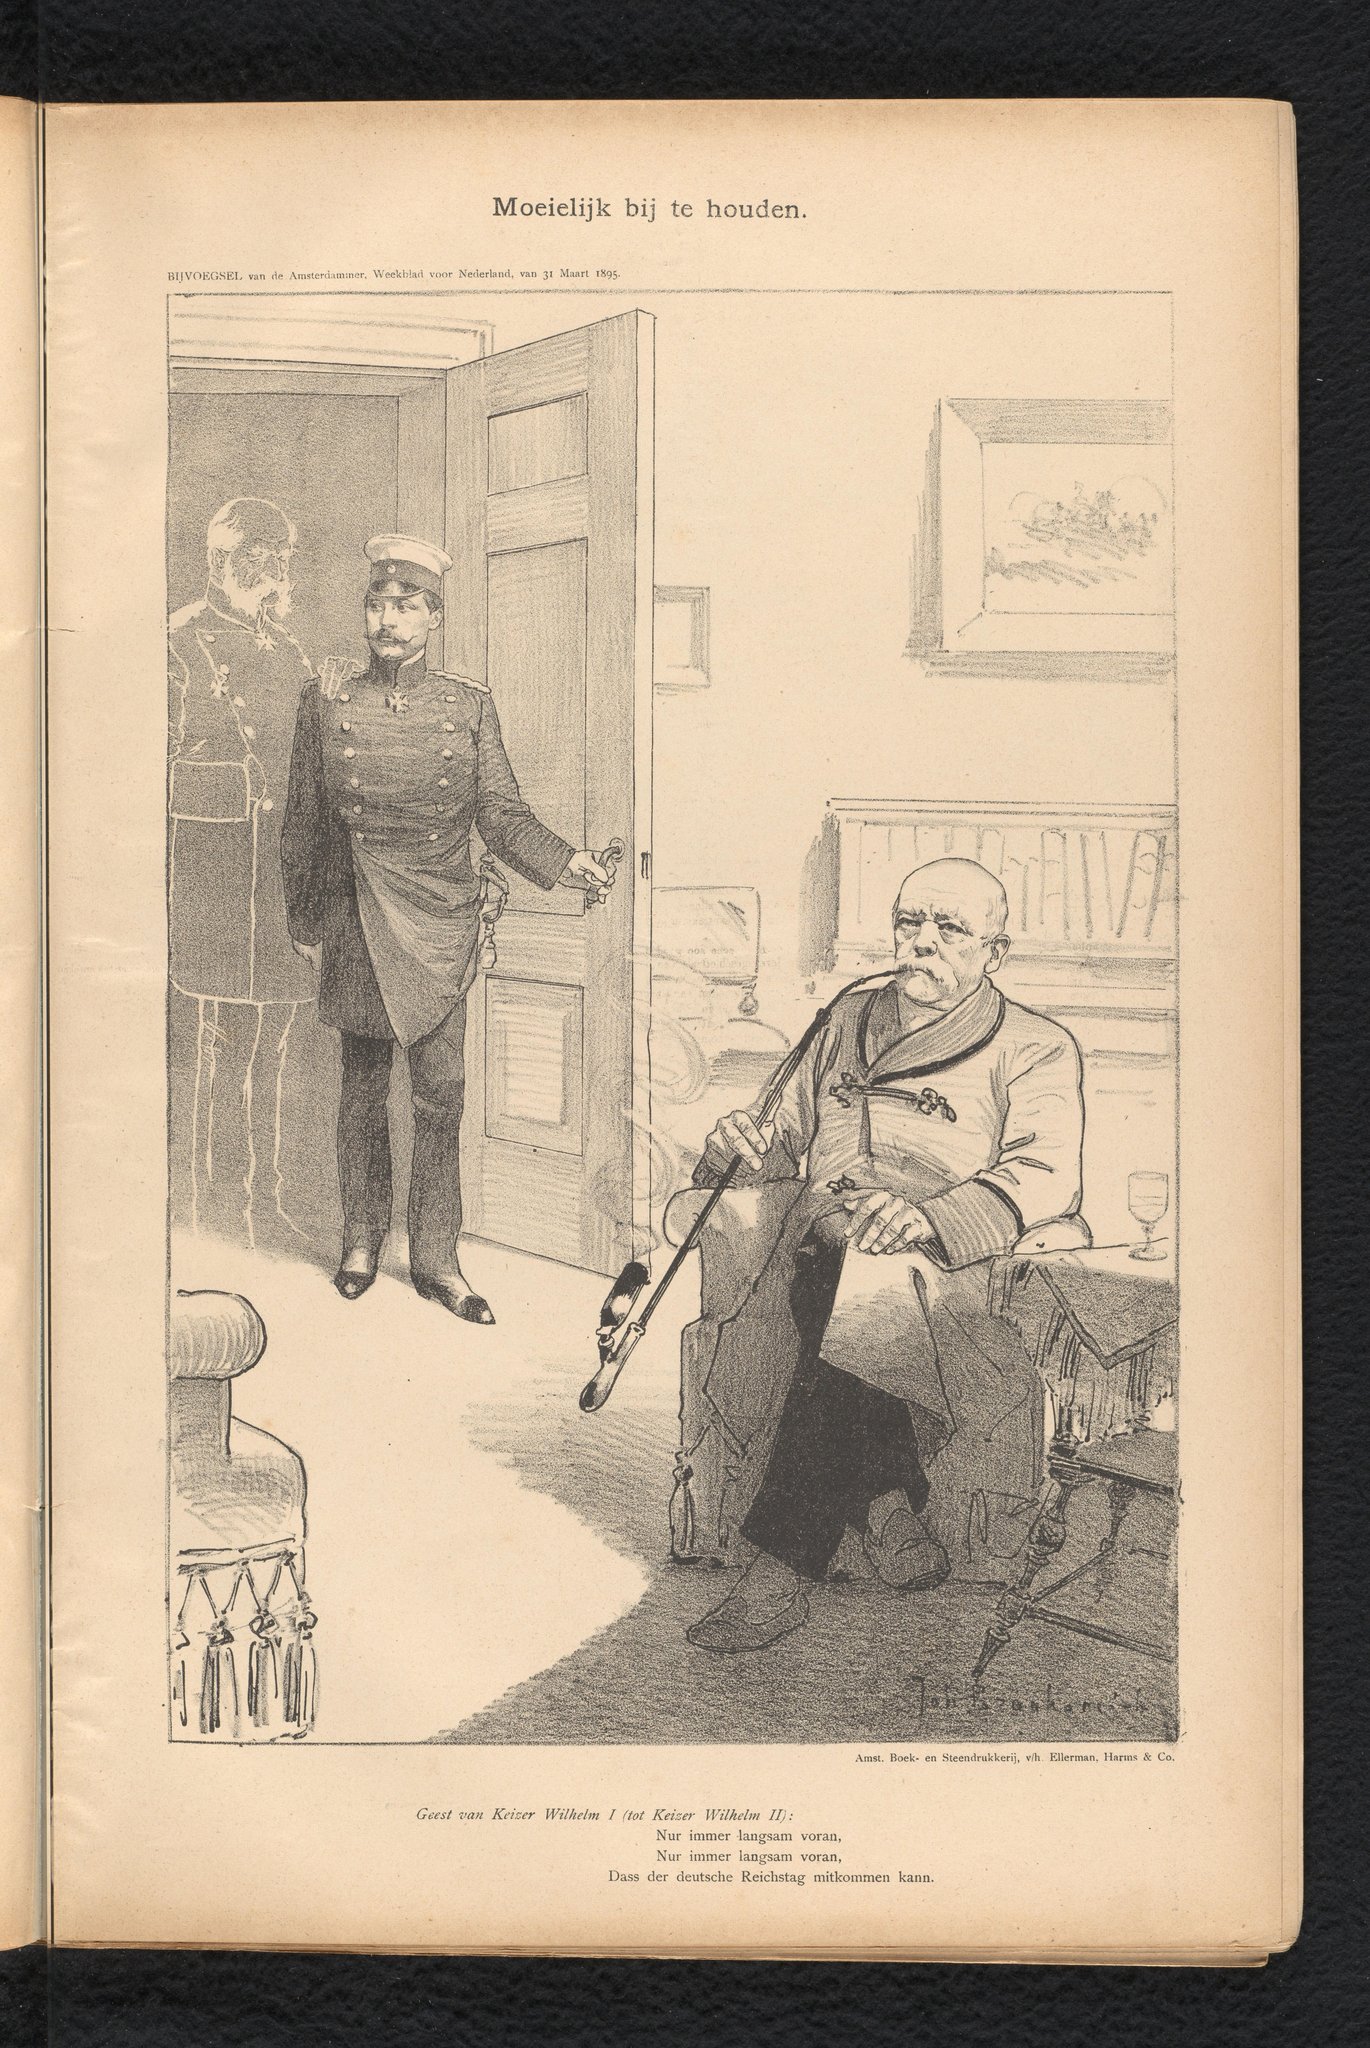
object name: cartoon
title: Moeielijk bij te houden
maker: johan braakensiek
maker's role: draughtsman, print maker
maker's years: 1858-1940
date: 1895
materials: paper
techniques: lithograph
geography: amsterdam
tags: berlin, wilhelm i (keizer van duitsland), wilhelm ii (keizer van duitsland), poland, politician, spirit, ghost, political caricatures and satires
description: De schim van de Duitse keizer Wilhelm I adviseert zijn zoon Wilhelm II om de voormalige rijkskanselier Leo von Caprivi voorzichtig te benaderen.